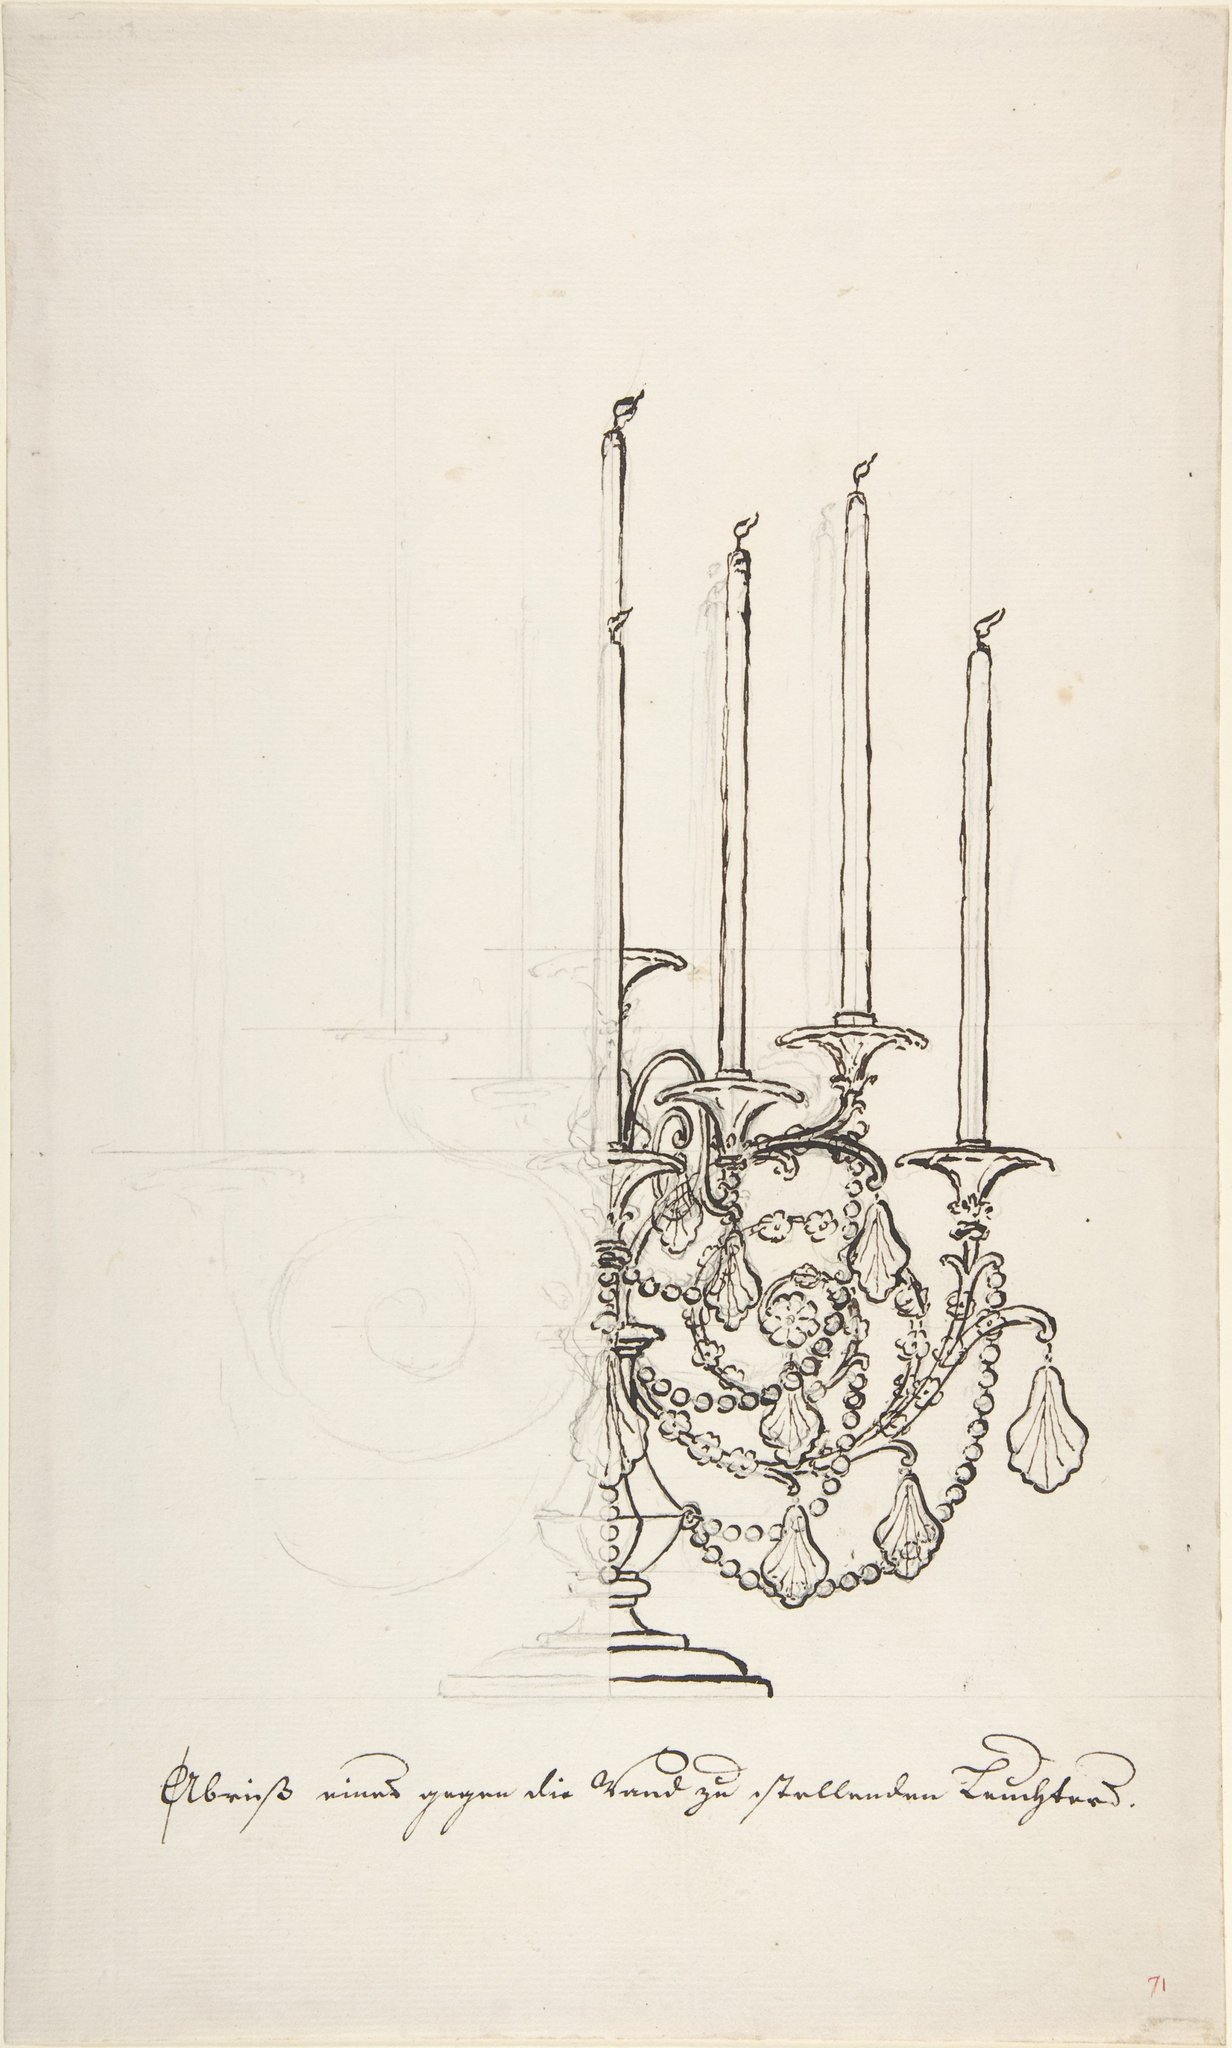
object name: drawing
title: Design for a Candelabra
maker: anonymous, french, 18th century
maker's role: artist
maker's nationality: french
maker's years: 1700-1800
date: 1770-1790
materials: graphite, ink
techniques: pen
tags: candelabra